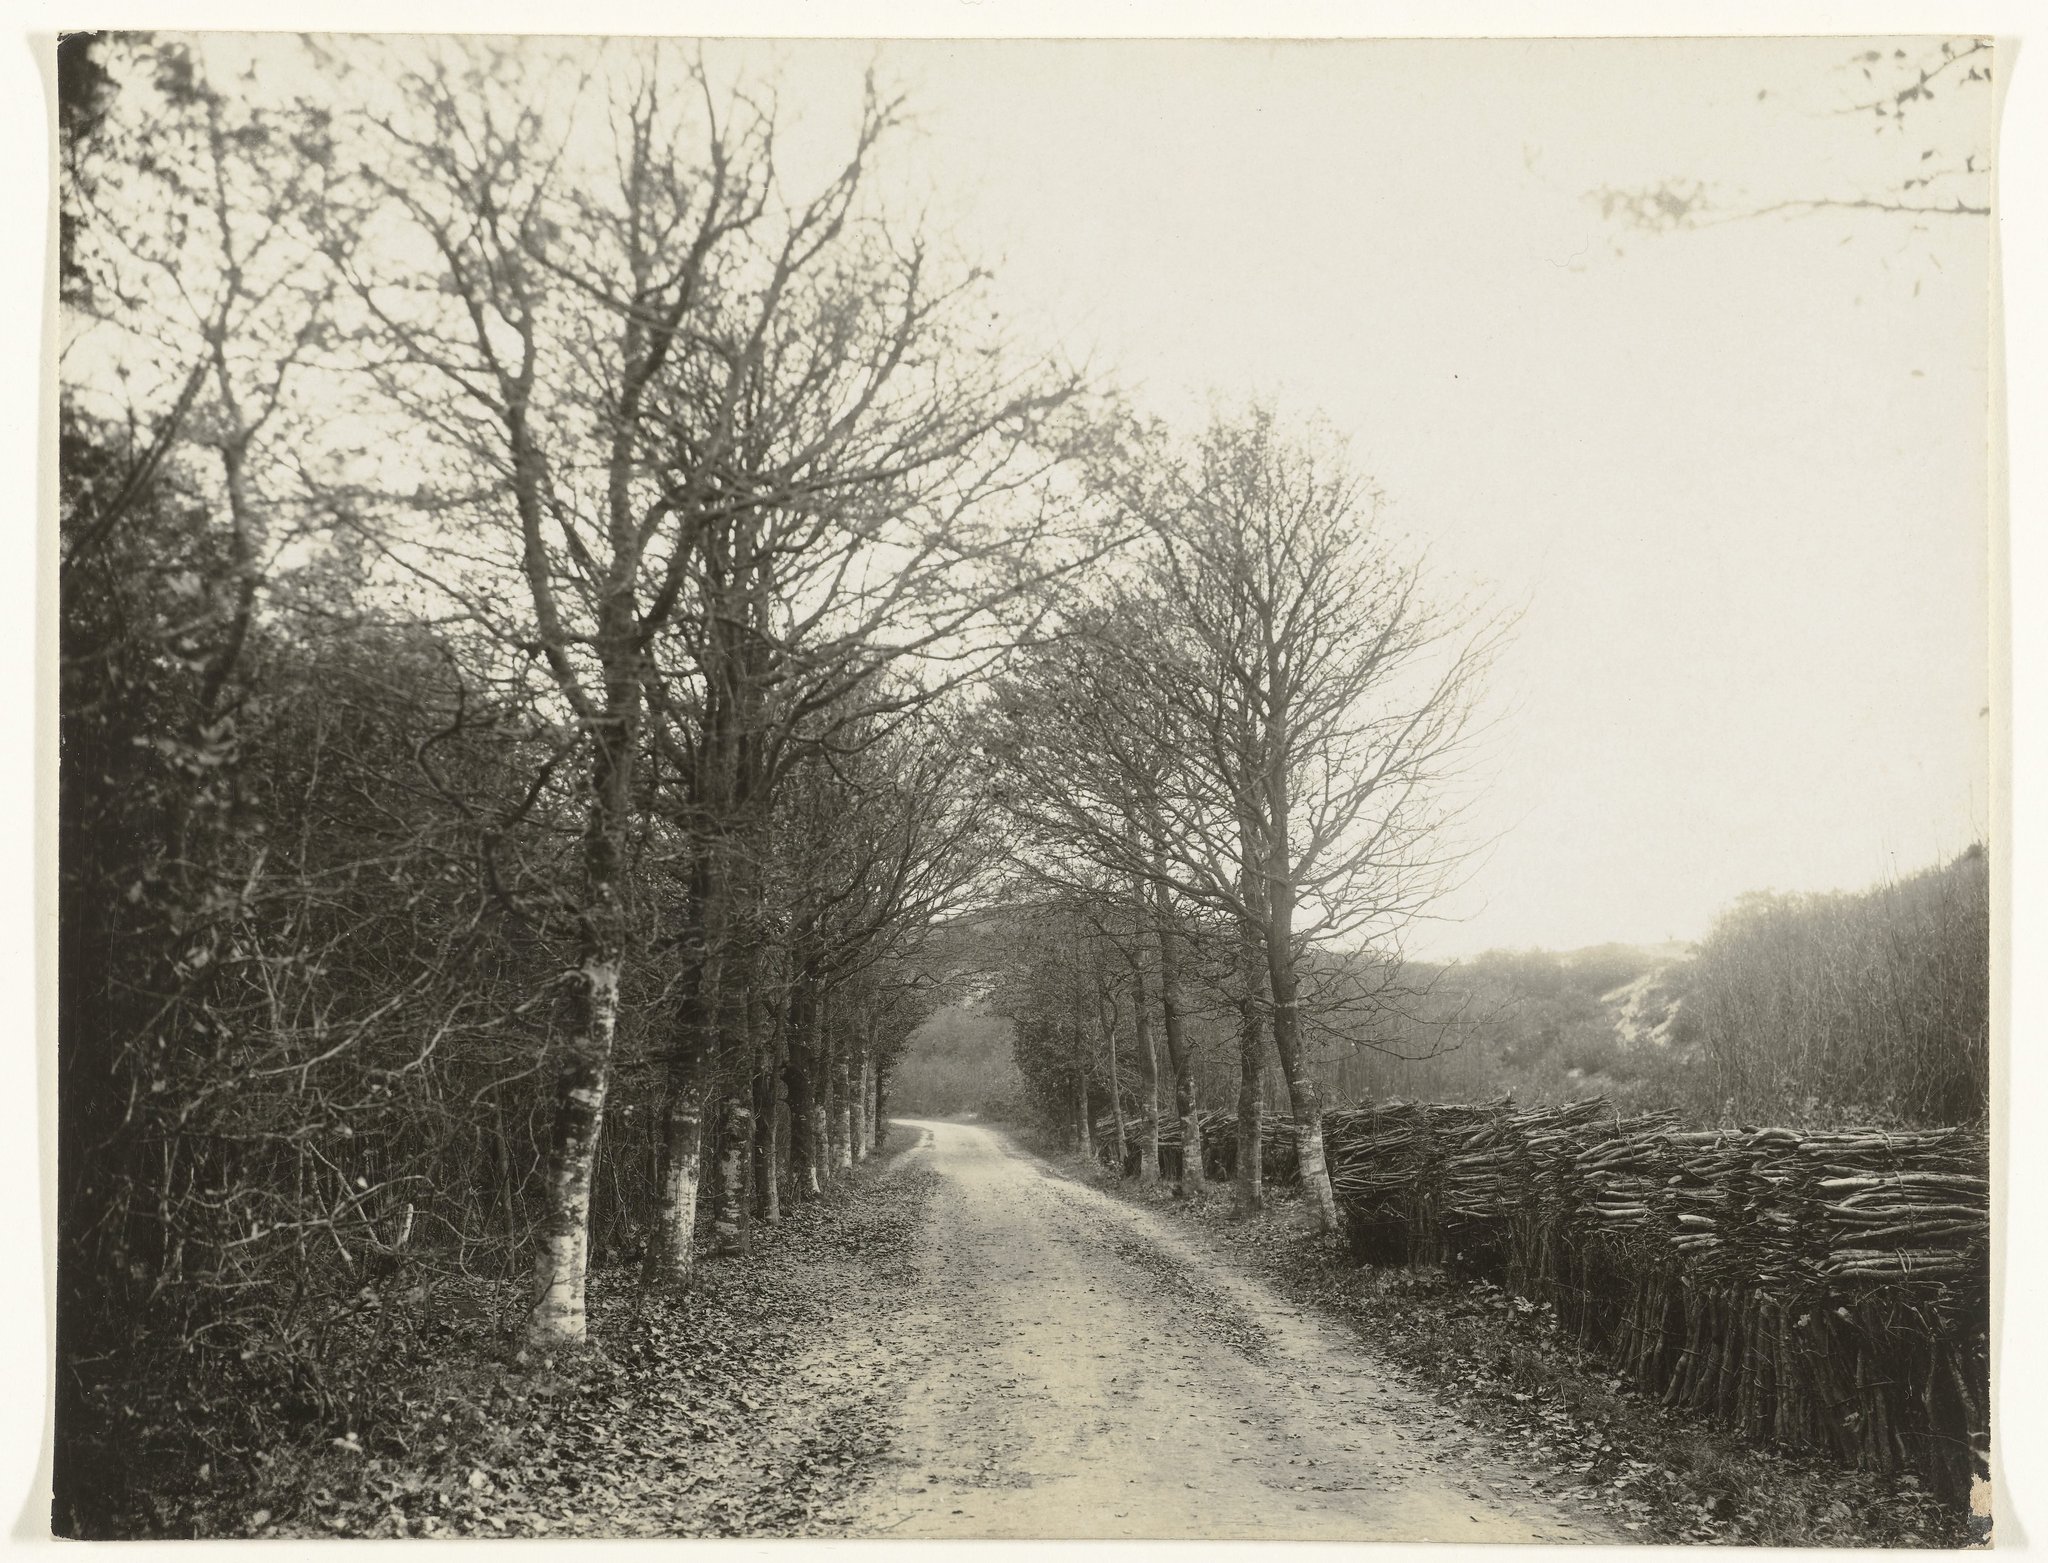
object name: photograph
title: Gezicht op de Eeuwige Laan in Bergen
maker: richard tepe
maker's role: fotograaf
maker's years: 1864-1952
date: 1900-1930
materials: photographic support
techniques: gelatin silver print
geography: netherlands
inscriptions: annotation: ‘Eewige [sic] Laan van Beuken / in den winter / te Bergen (NH)’, signature: ‘foto / R. Tepe’